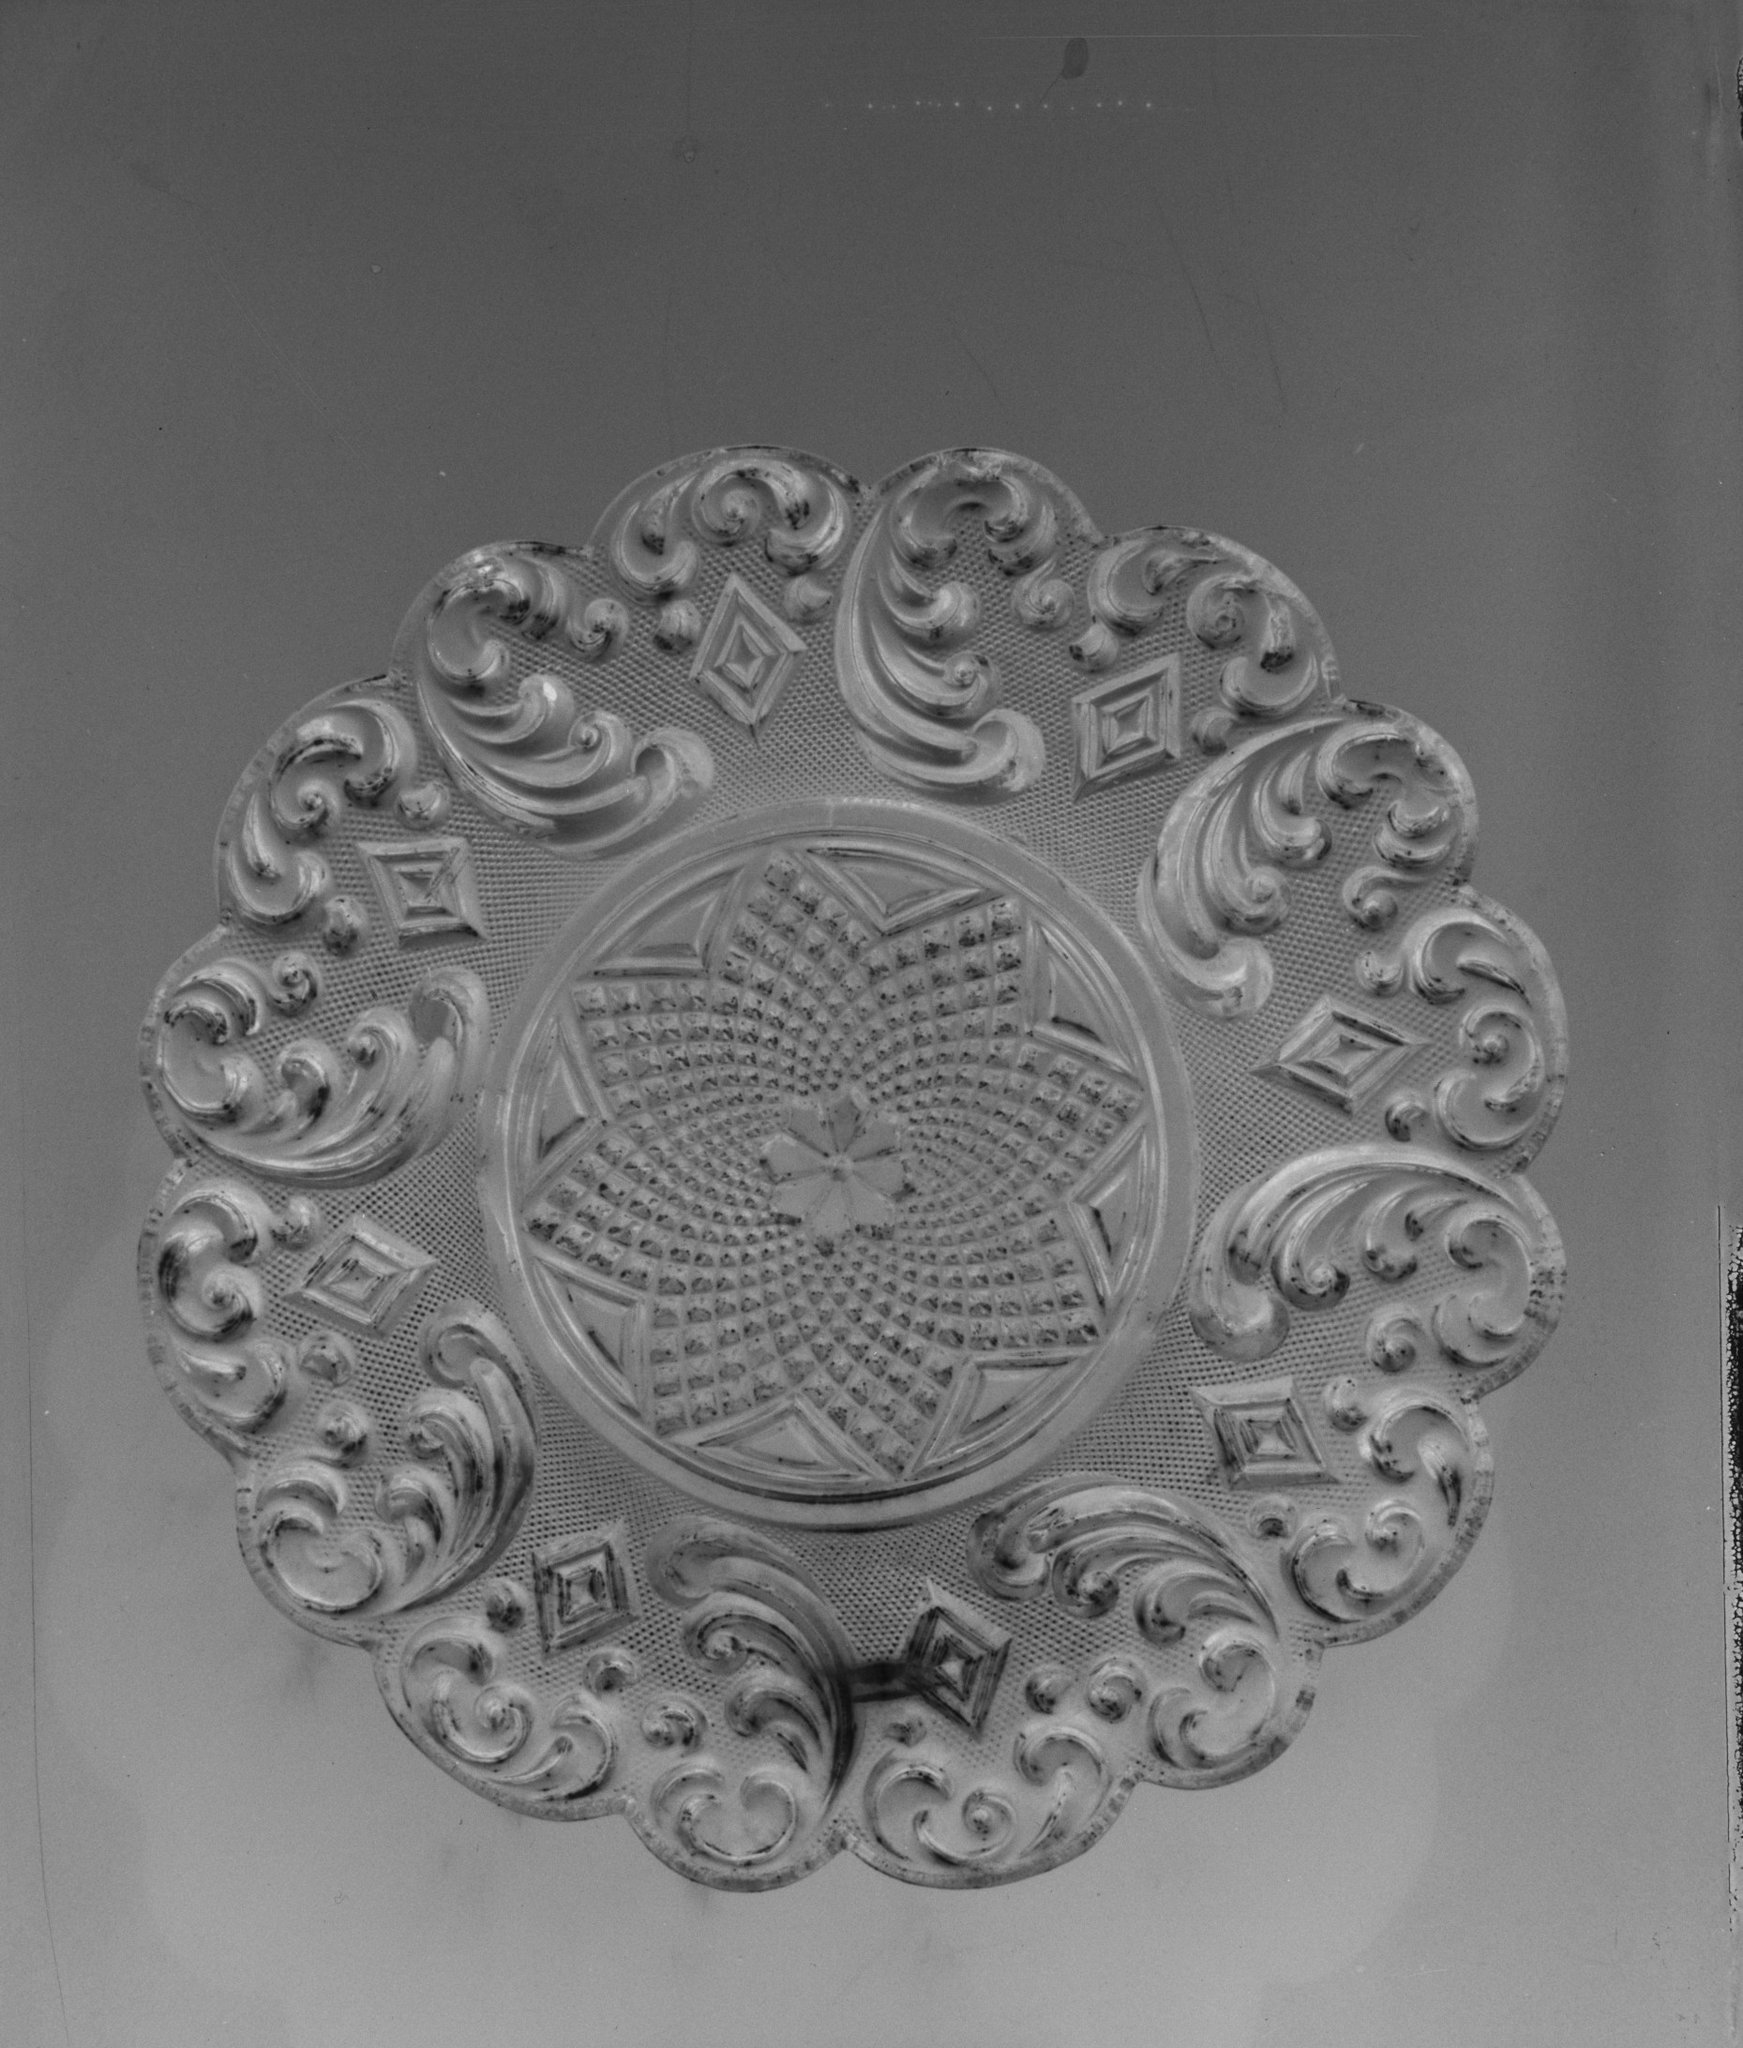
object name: dish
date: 1830-1850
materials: glass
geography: france